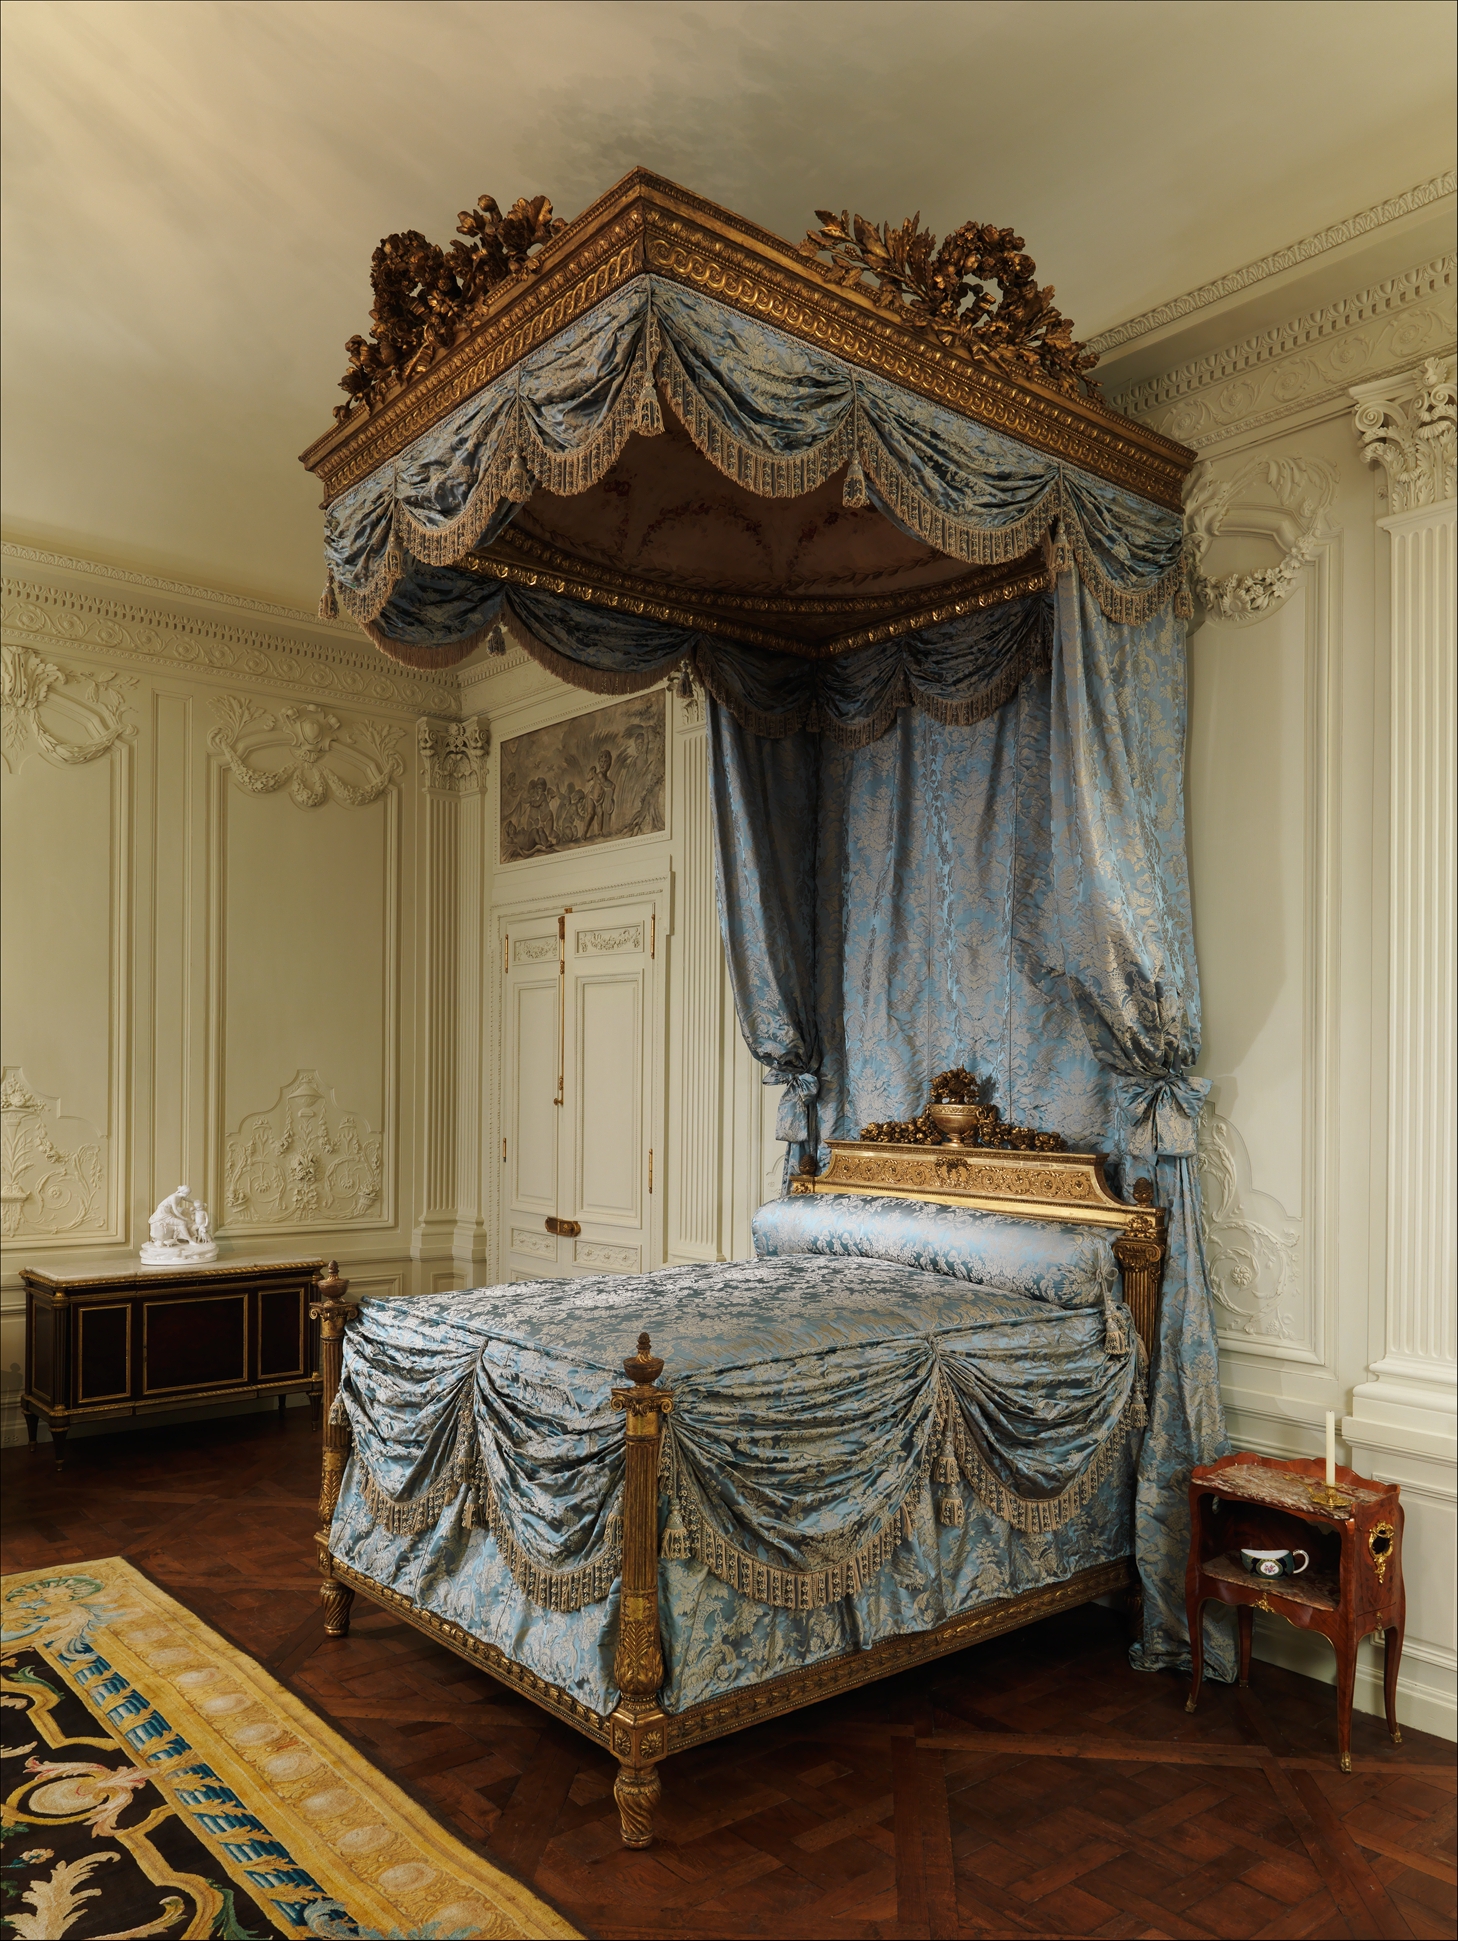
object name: bed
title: Tester bed (lit à la duchesse en impériale)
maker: georges jacob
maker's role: maker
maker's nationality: french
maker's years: 1739-1814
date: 1782-1783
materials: iron, wood, silk, wool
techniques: carving, damask, gilding, painting, tapestry